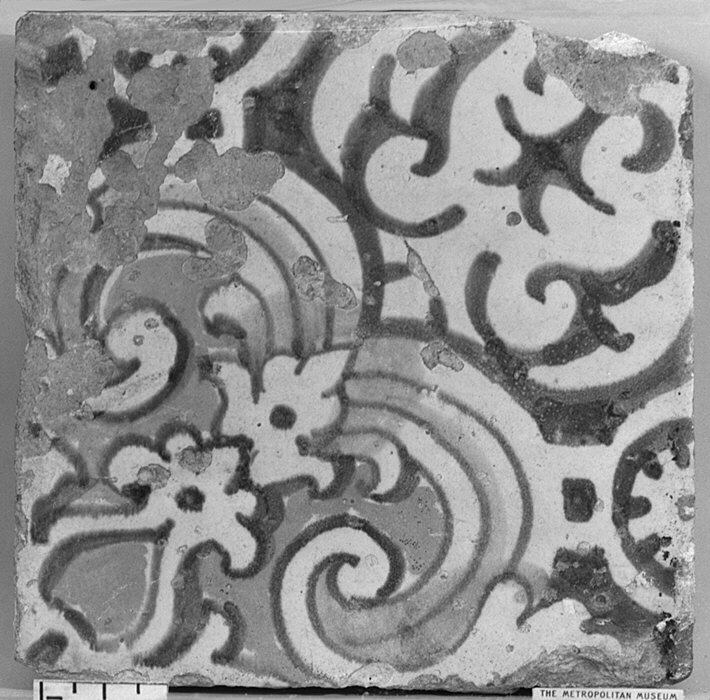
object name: floor tile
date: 1580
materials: earthenware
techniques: glazing